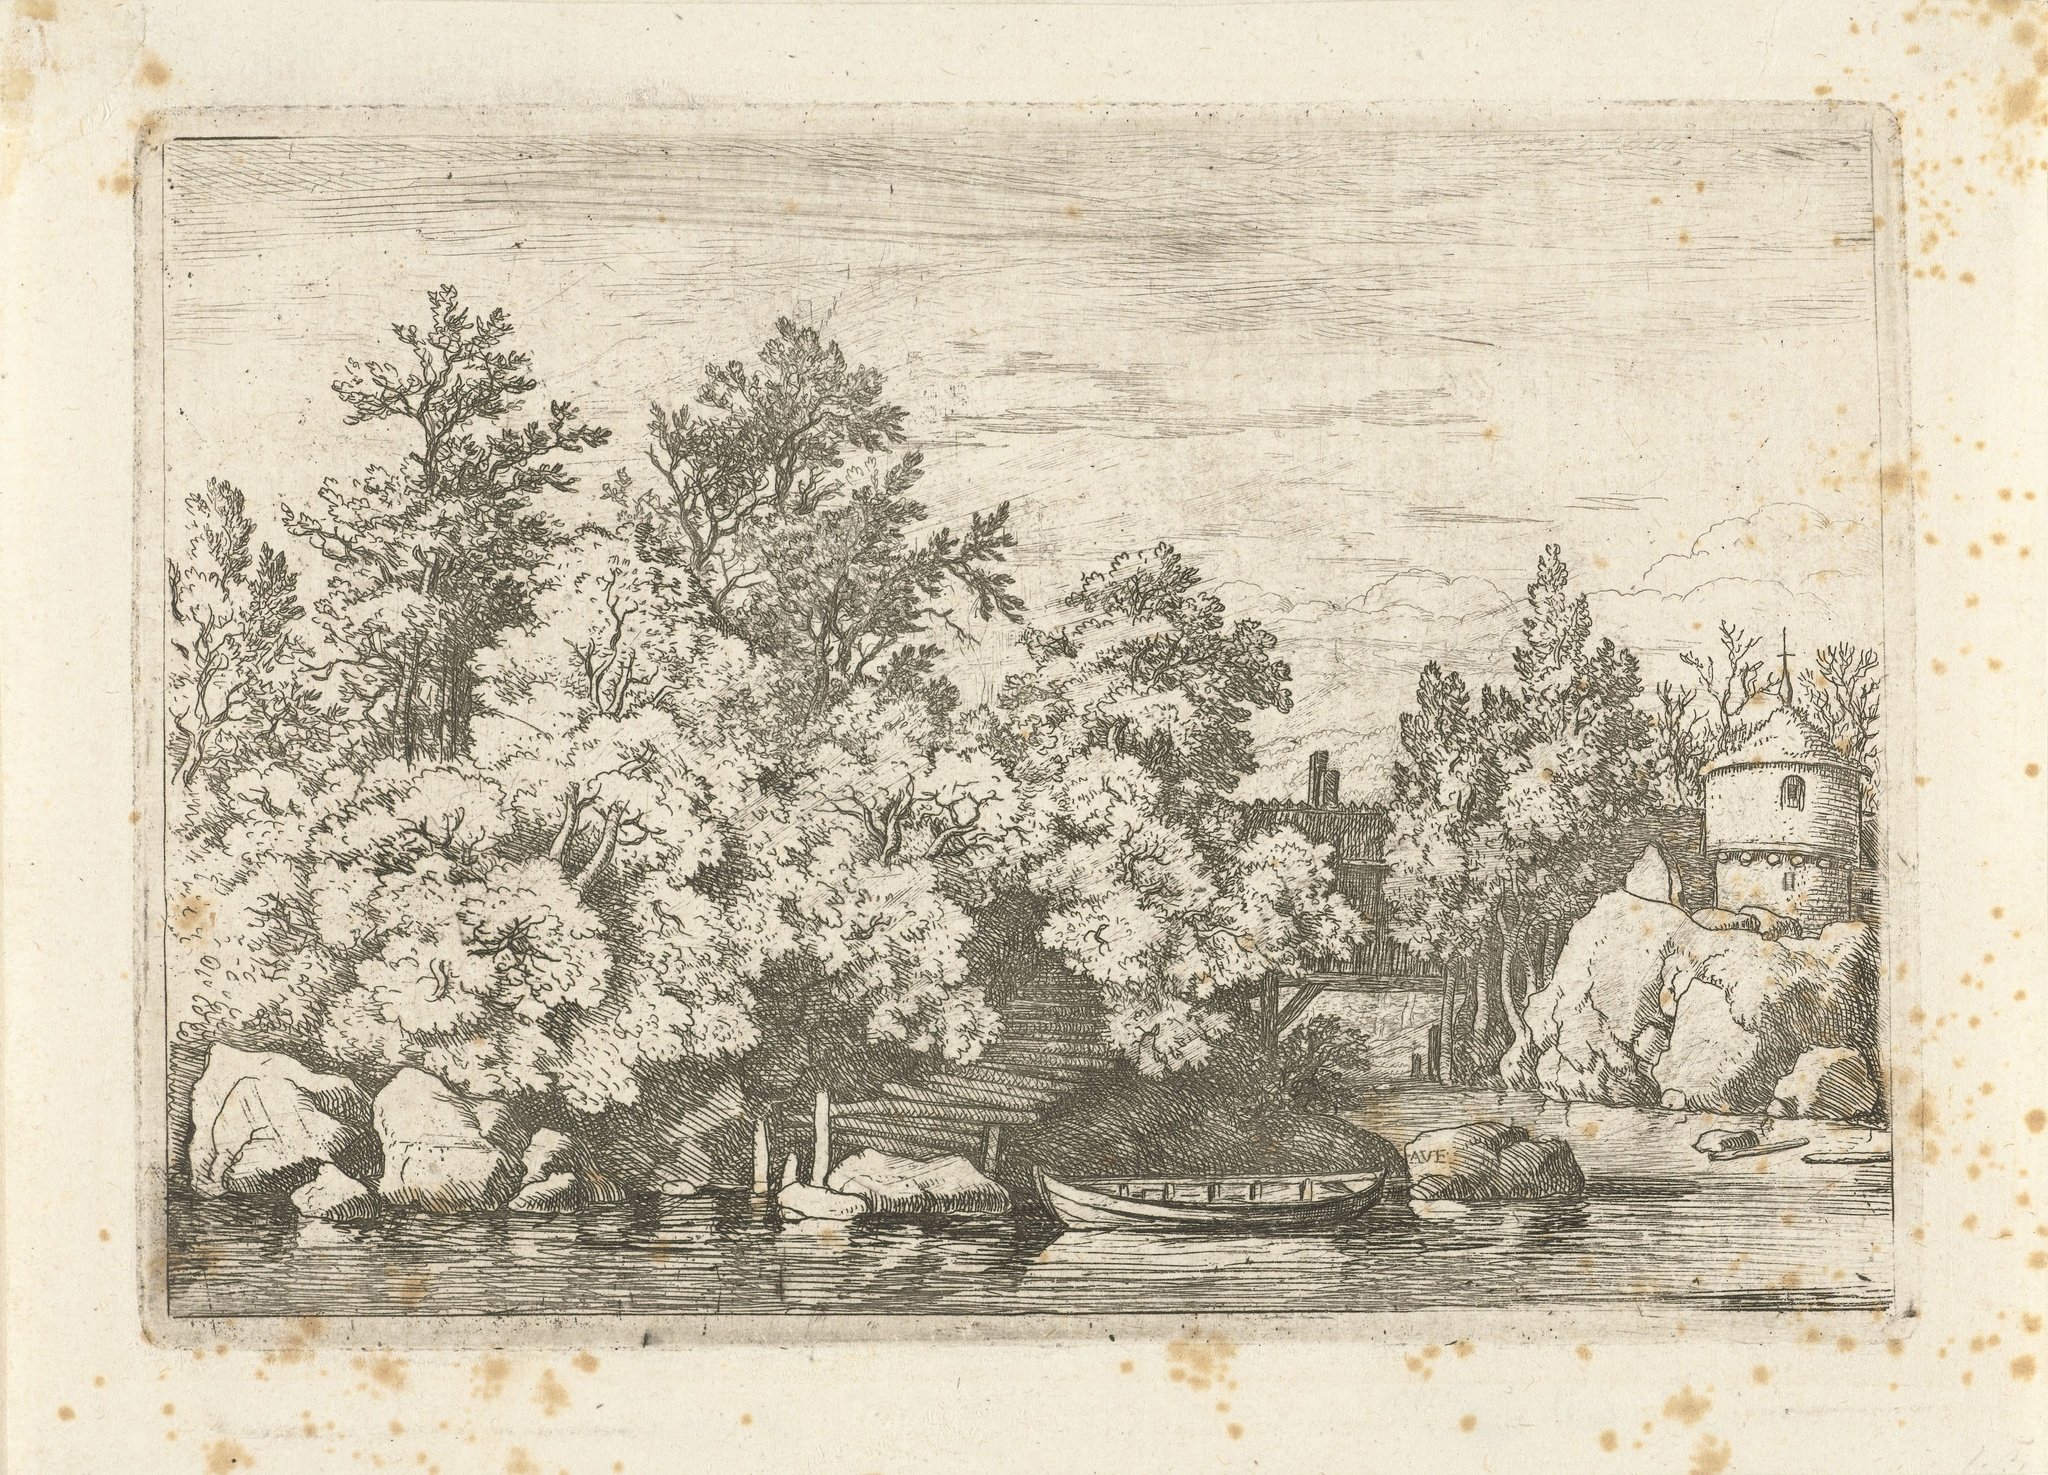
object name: print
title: Landschap met overdekte brug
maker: allaert van everdingen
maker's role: draughtsman, painter, print maker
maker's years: 1621-1675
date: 1631-1675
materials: paper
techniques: etching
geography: netherlands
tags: landscape with bridge, viaduct or aqueduct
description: Gezicht op een roeiboot langs de dichtbegroeide oever van een rivier. Op de achtergrond een torentje en een overdekte brug.